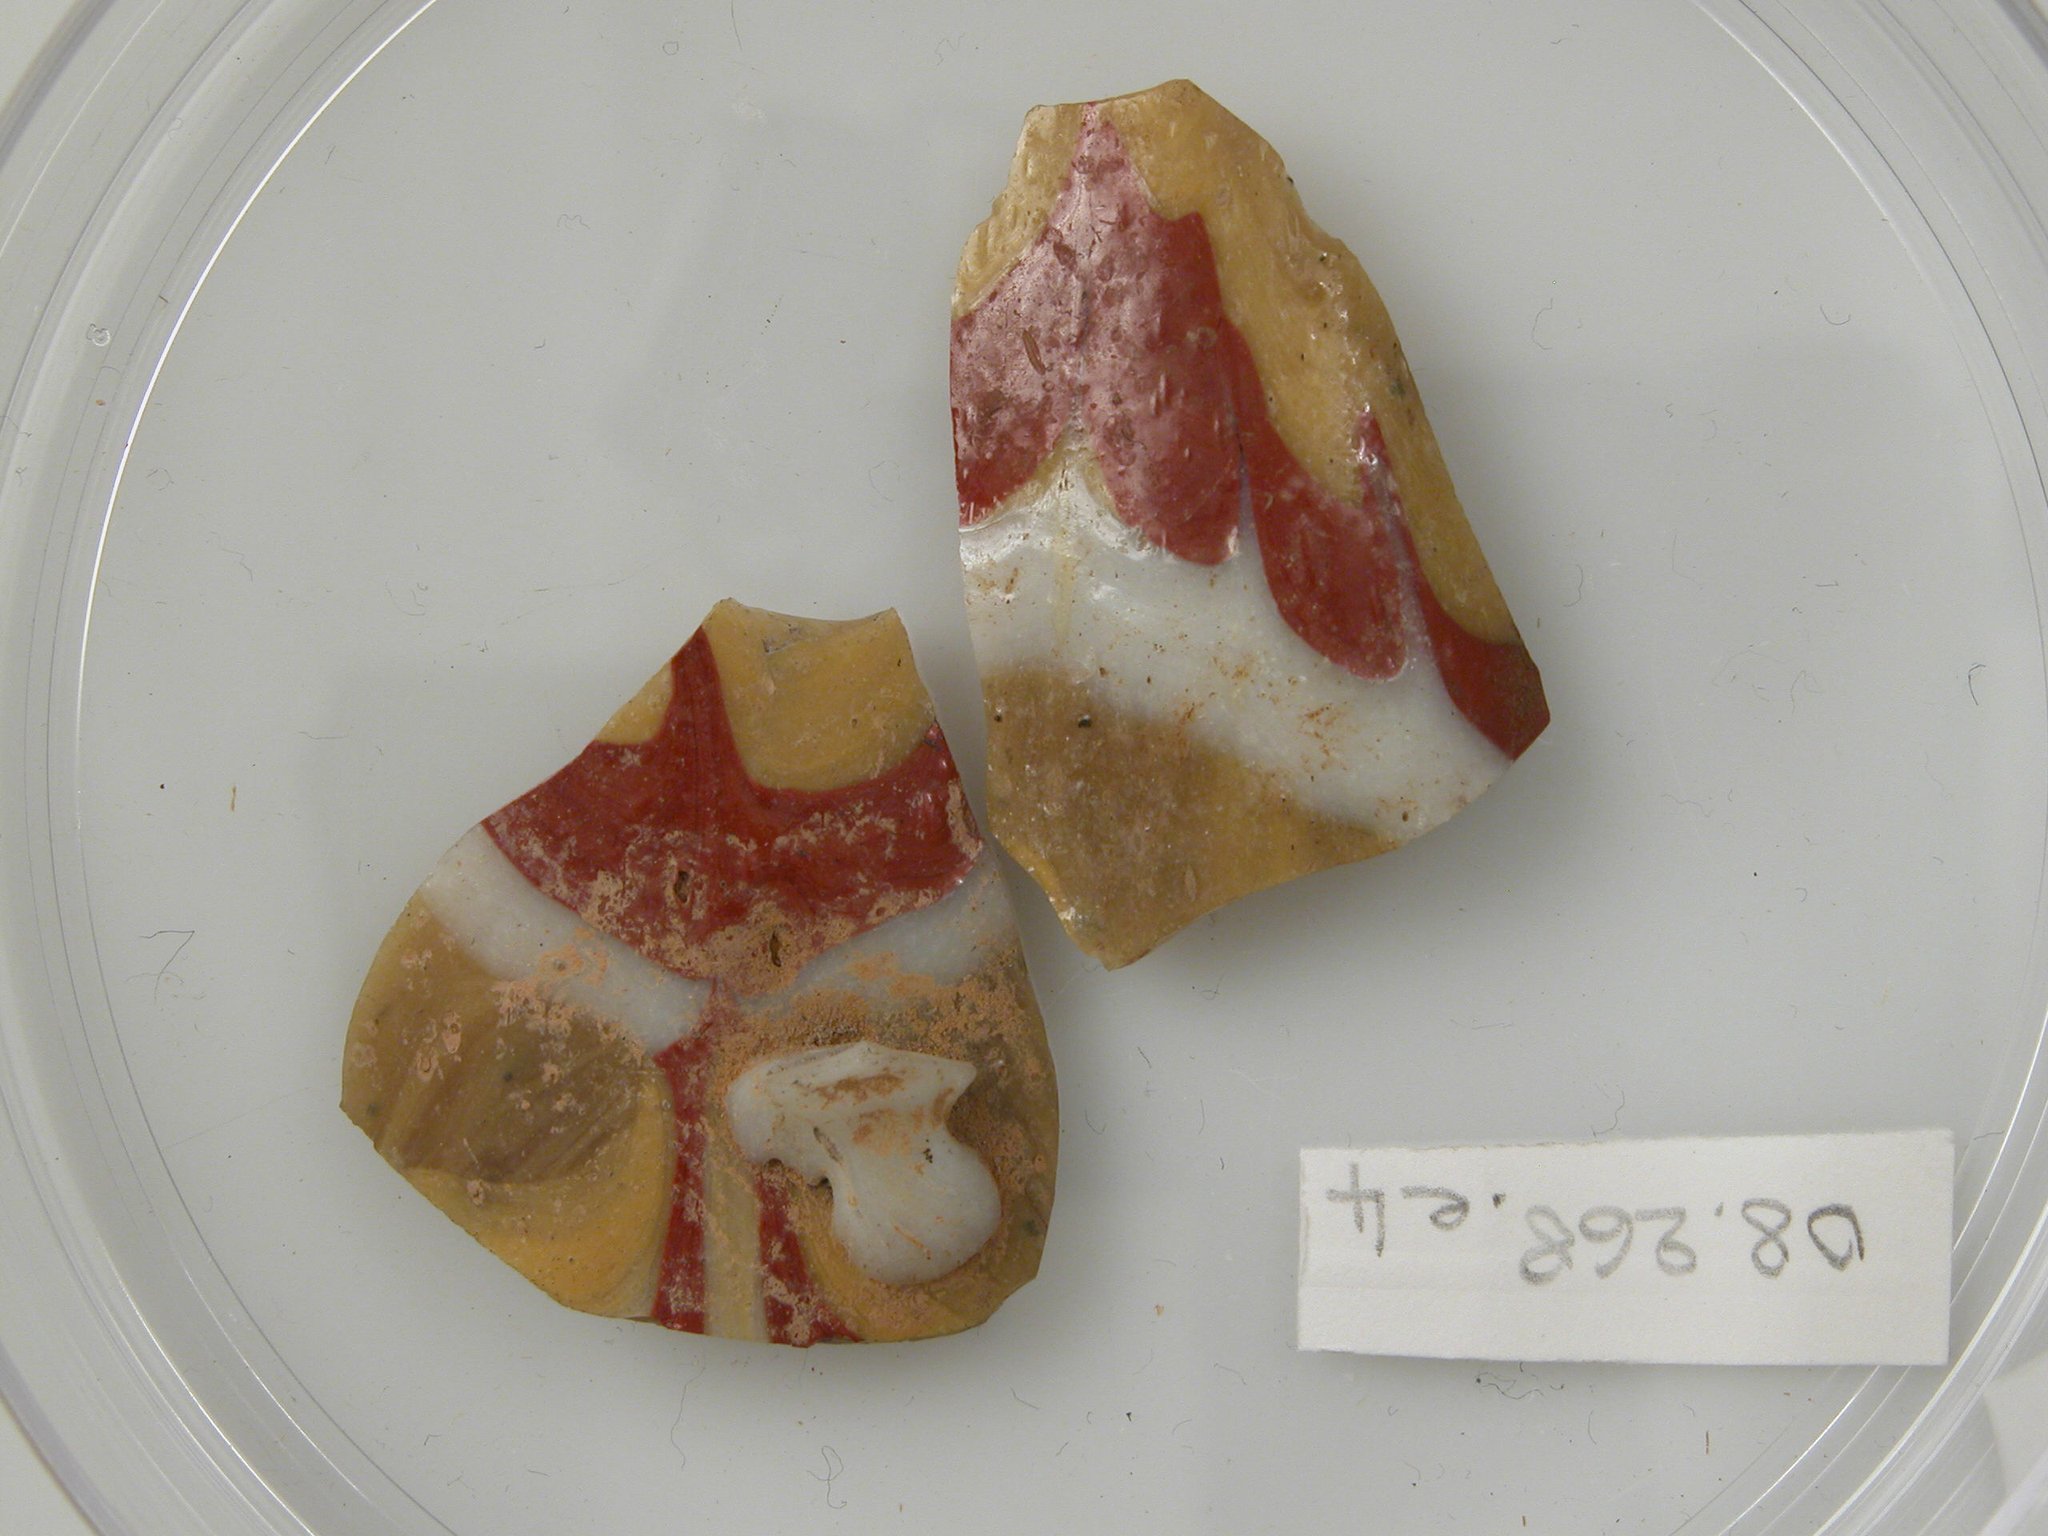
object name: fragment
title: Glass Fragments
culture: coptic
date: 301-433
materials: glass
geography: egypt